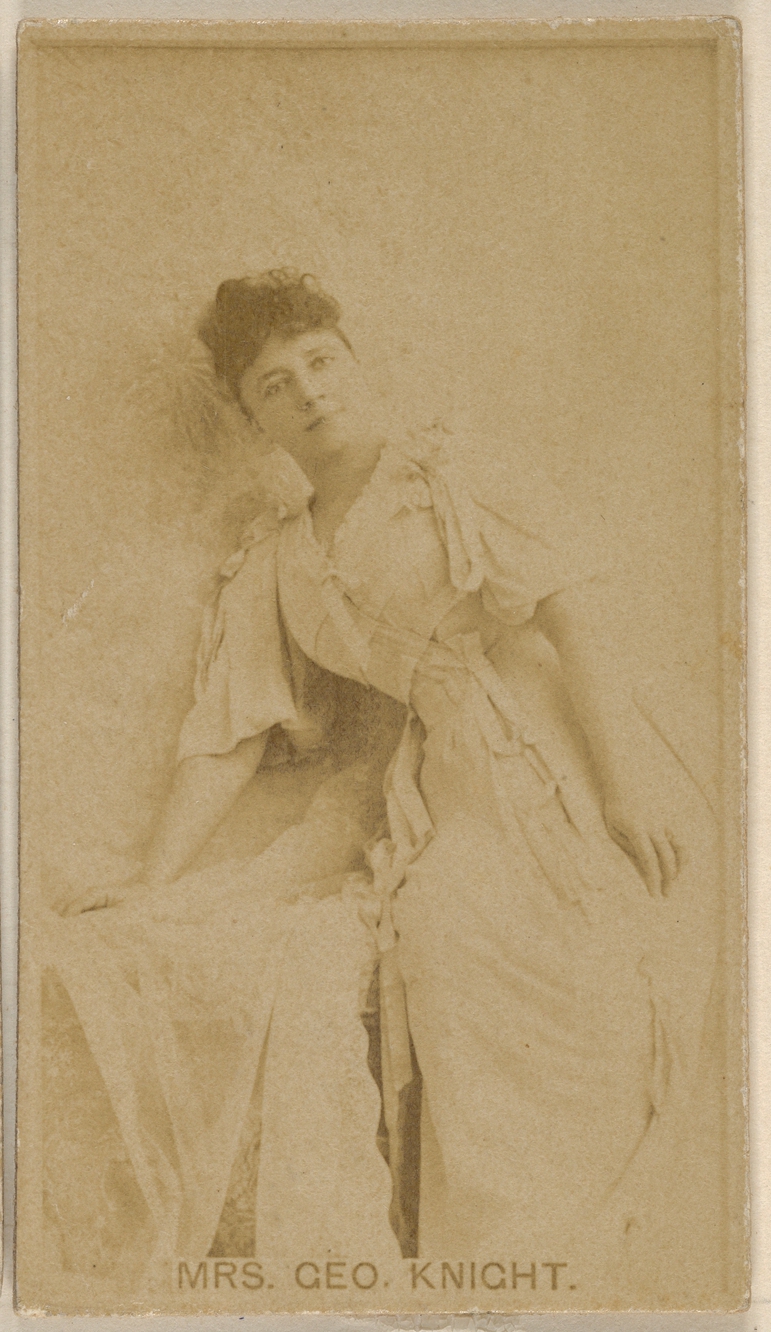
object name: photograph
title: Mrs. George Knight, from the Actors and Actresses series (N45, Type 8) for Virginia Brights Cigarettes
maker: allen & ginter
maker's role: publisher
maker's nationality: american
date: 1888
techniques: albumen silver print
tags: portraits,women,actresses